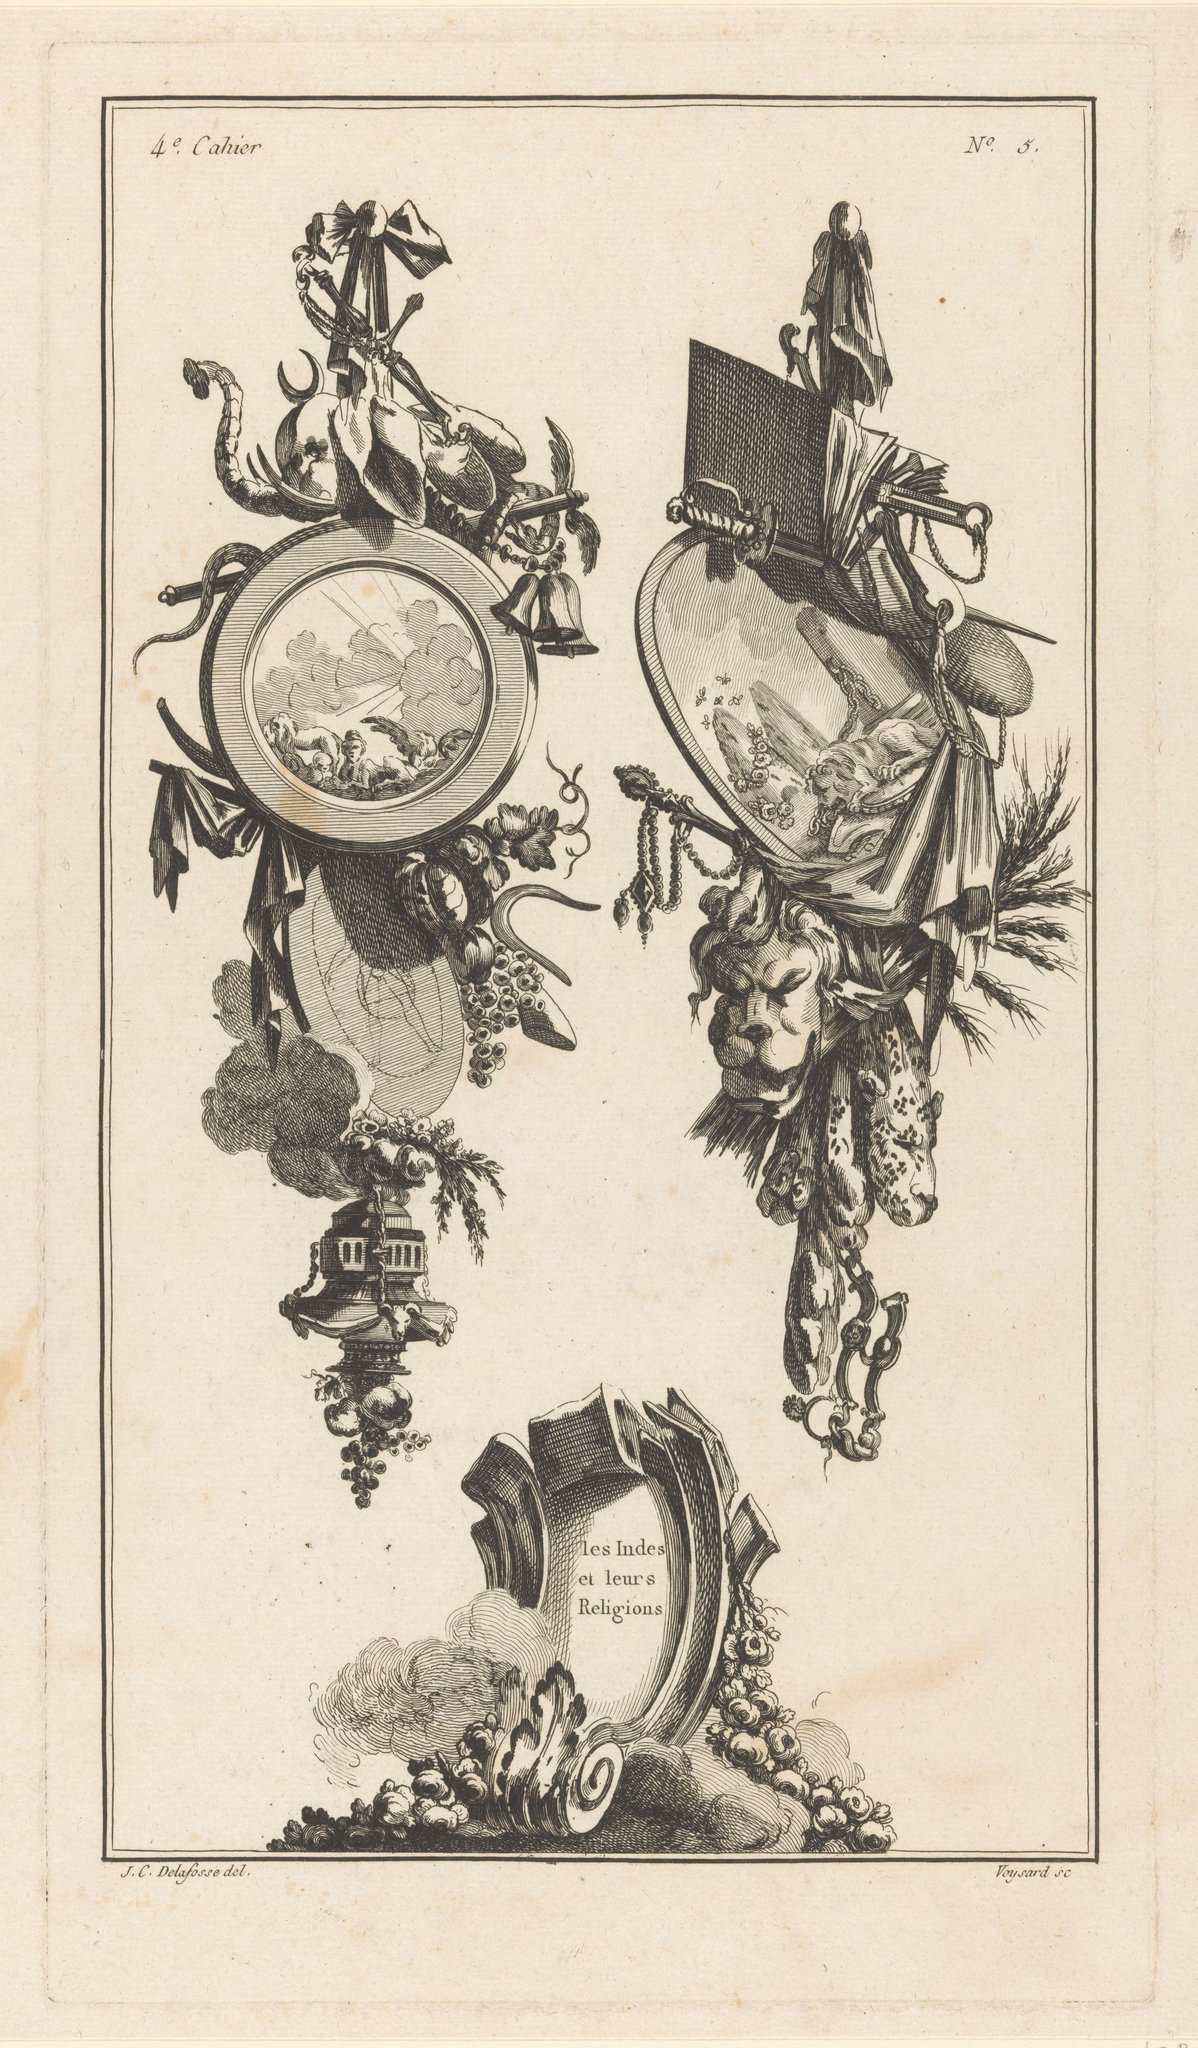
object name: ornament print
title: Indië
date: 1772-1779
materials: paper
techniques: engraving, etching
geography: paris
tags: trophy, i.e.: decorative arrangement of symbolic or typical objects ~ ornament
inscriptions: collector's mark: Lugt 2228, collector's mark: Lugt 2760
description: Twee trofeeën met schilden. Links met wapens, een olifantenkop, een caduceus, druiven, een rookvat en een schild met dieren. Rechts met wapens, een leeuwenvel, een pantervel en een schild met een geketende leeuw.